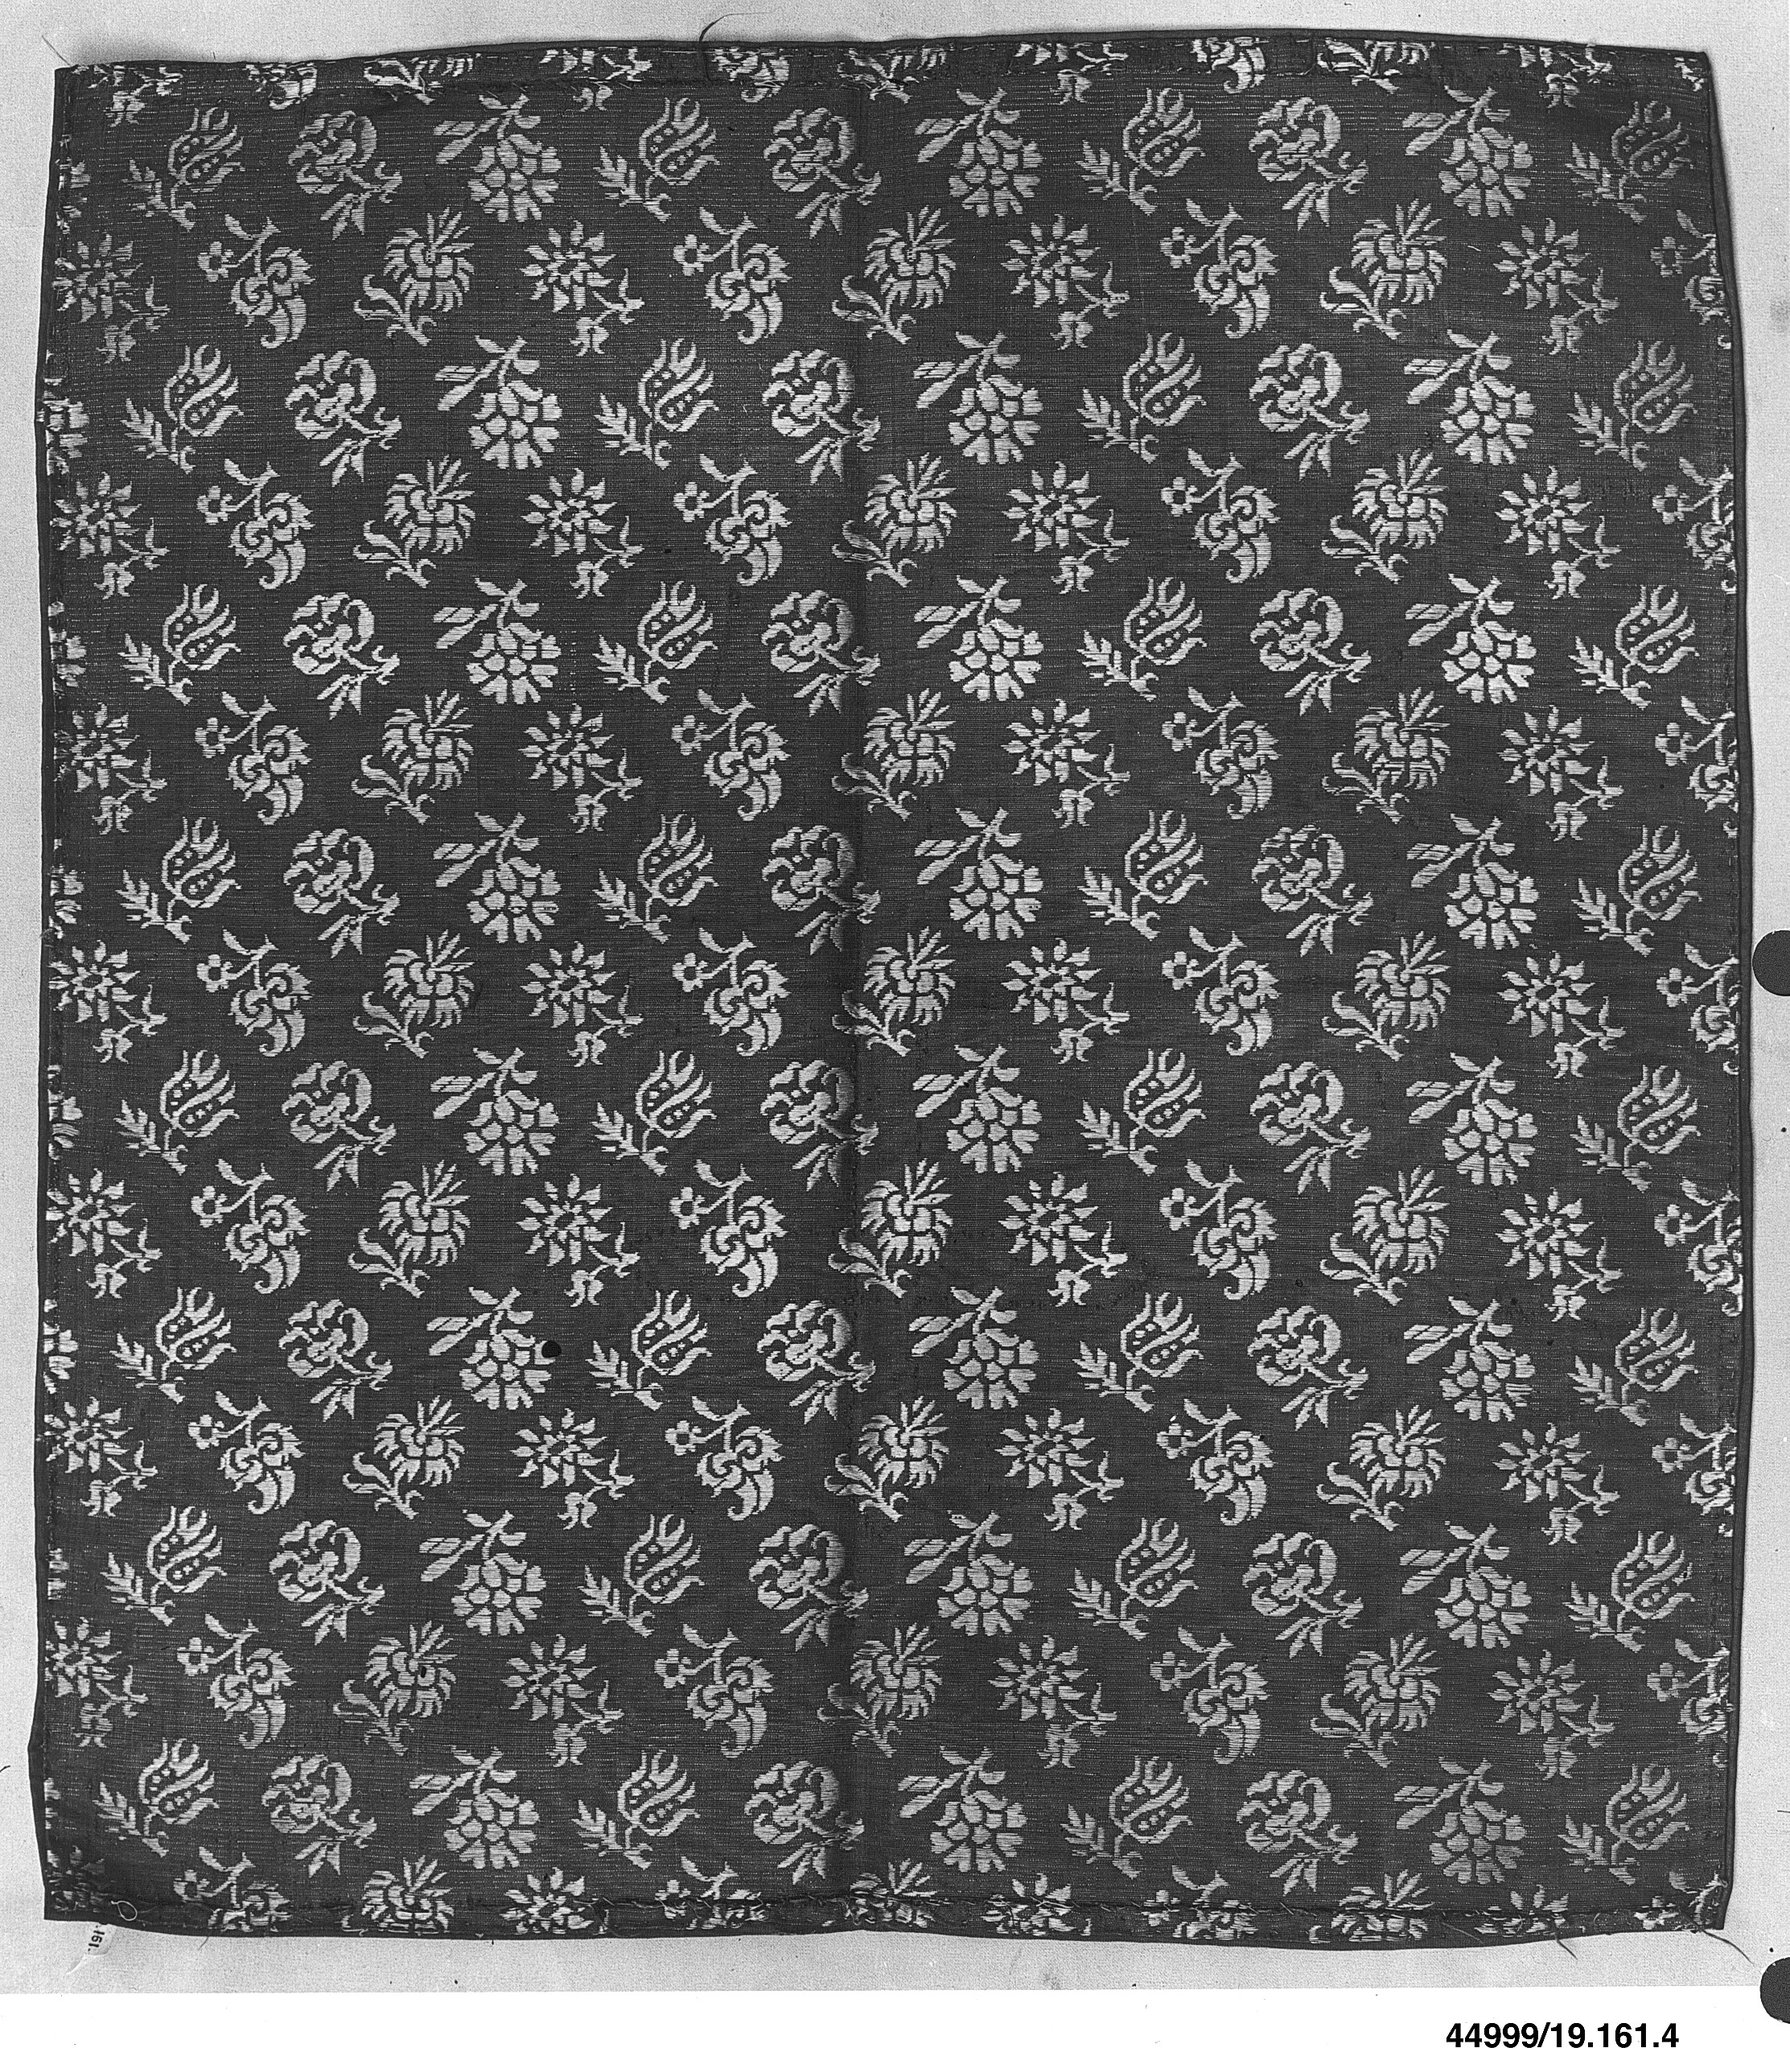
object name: piece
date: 1601-1700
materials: metal thread, silk